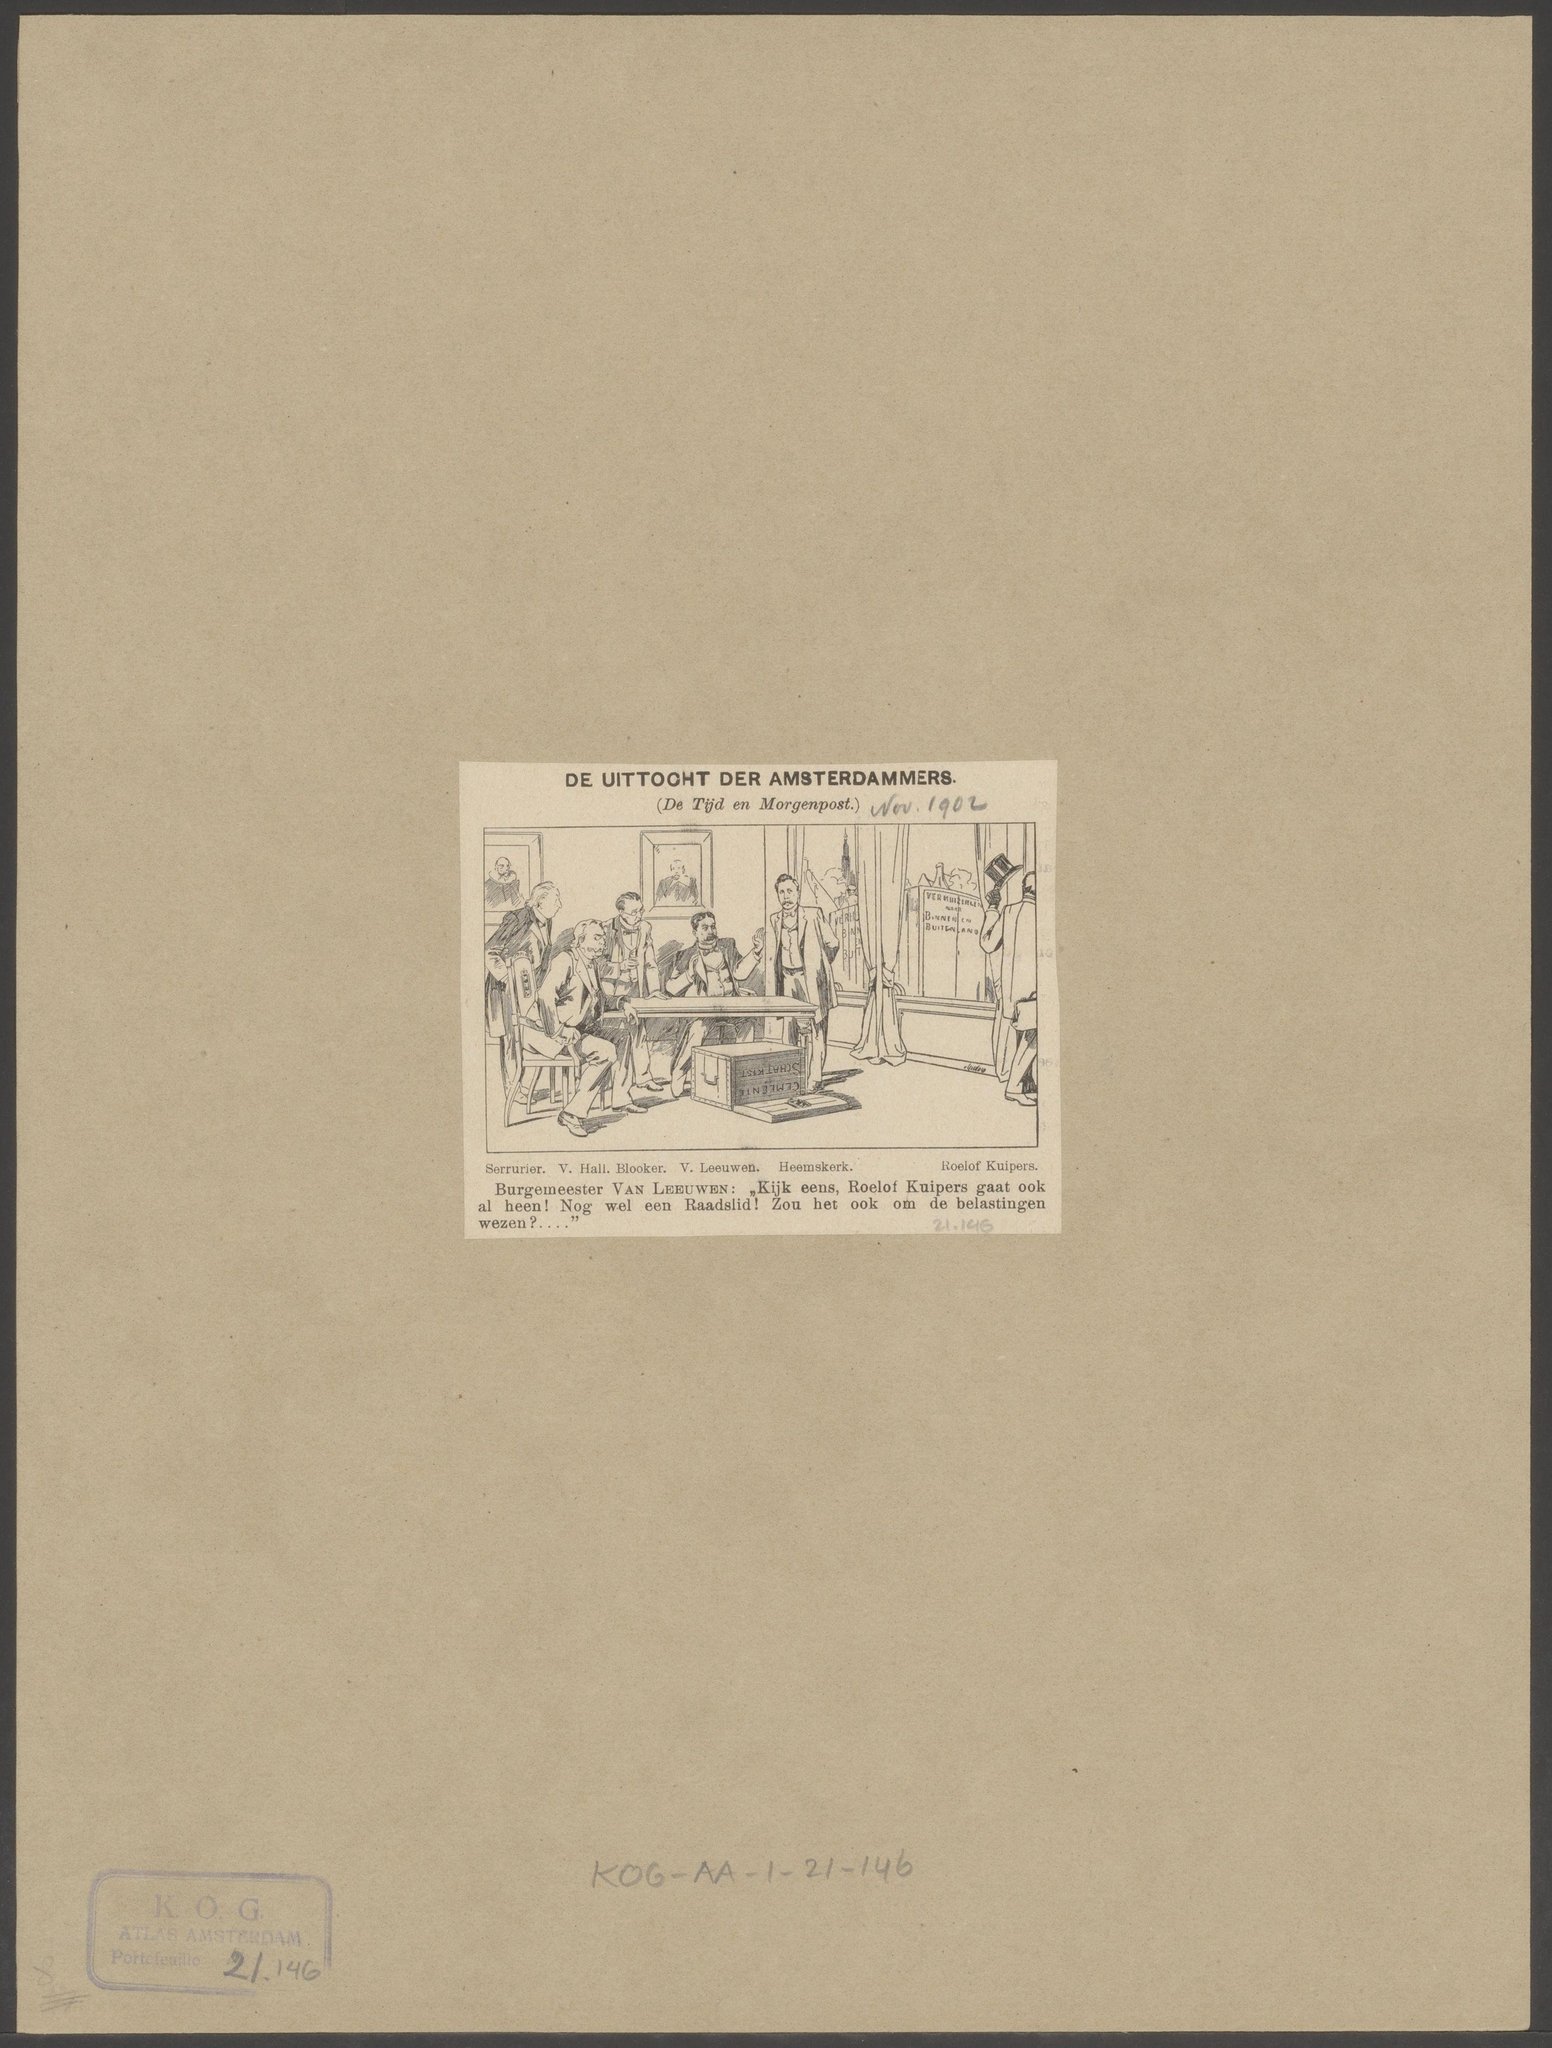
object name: photomechanical print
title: De uittocht der Amsterdammers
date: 1902-1911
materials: paper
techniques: letterpress printing, line block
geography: netherlands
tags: utrecht, amsterdam, politician, jacob nicolaas van hall, surabaya, the hague, politician, e.g. party leader, political caricatures and satires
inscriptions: collector's mark: Lugt 1641b, inscription: ‘Nov. 1902’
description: Prent komt uit een onbekende publicatie, waarschijnlijk uit november 1902. Een vergelijkbare prent werd eerder gepubliceerd in: Geïllustreerd zondagsblad voor katholieken, 26 oktober 1902, p. 132.